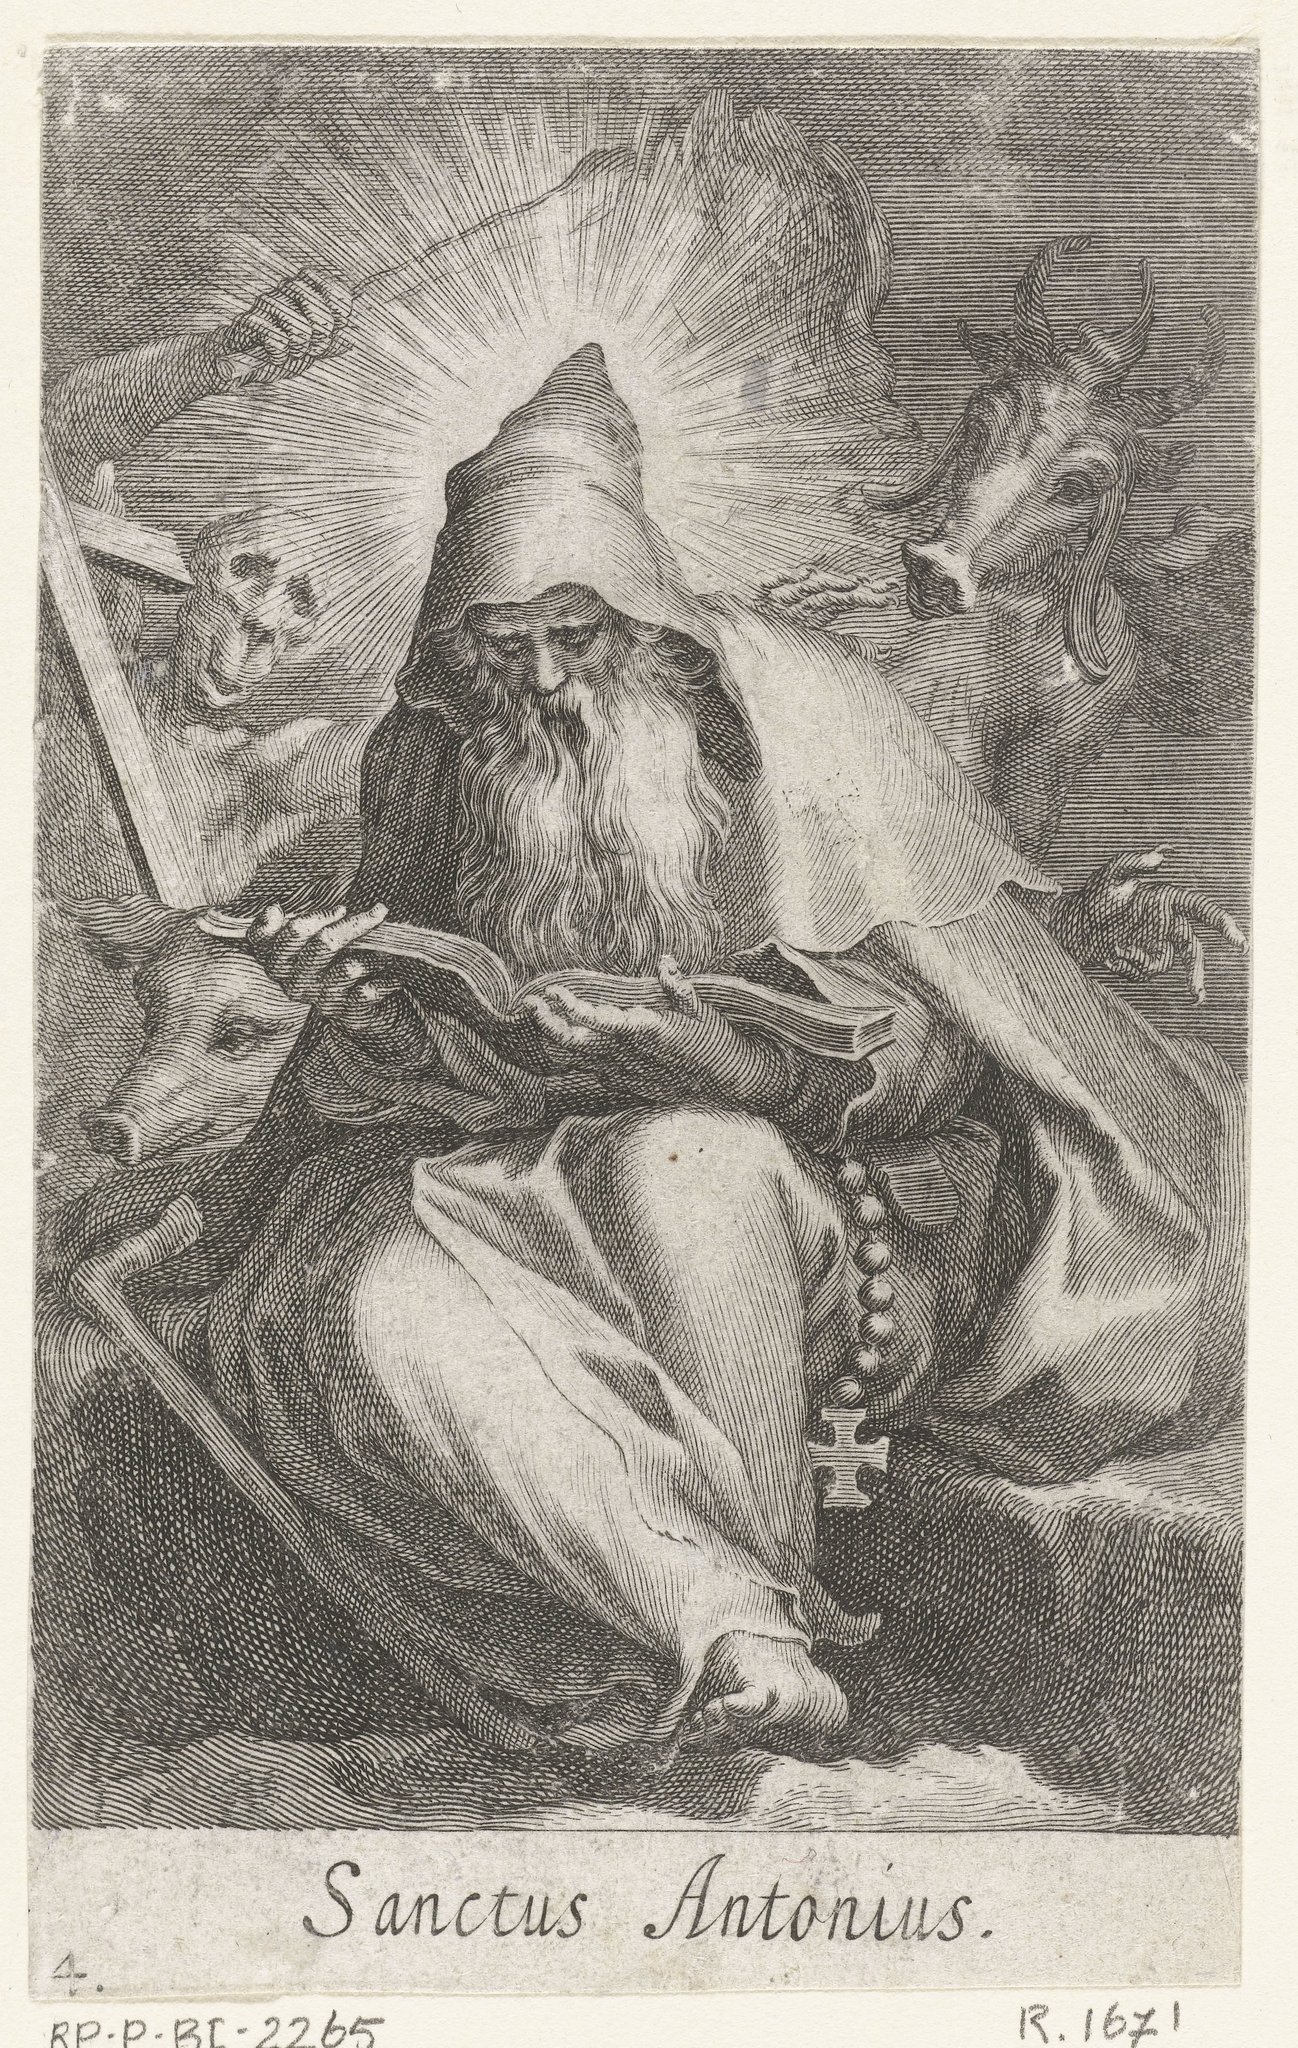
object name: print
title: Sacra eremvs ascetarvm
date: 1590-1612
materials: paper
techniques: engraving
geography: low countries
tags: anchorite, hermit, the hermit antony abbot (antonius abbas) of egypt, also called the great; possible attributes: bell, book, t-shaped staff, flames, pig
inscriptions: collector's mark: Lugt 240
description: Prent uit: Sacra eremus ascetarum, Antwerpen, Hendrick Aertssen, 1619. Eerste gebonden uitgave met in totaal vijftig prenten. Prent uit serie van vijfentwintig mannelijke kluizenaars. In 1612 verscheen een ongebonden editie maar op basis van de gewijzigde opschriften en samenstelling wordt aangenomen dat de prenten van de uitgave 1619 ook in 1612 of iets daarvoor gedrukt werden. Roethlisberger beschouwt de uitgave van 1619 als de eerste staat en de ongebonden editie van 1612 als de tweede staat (Roethlisberger 1993, p. 171, 172).